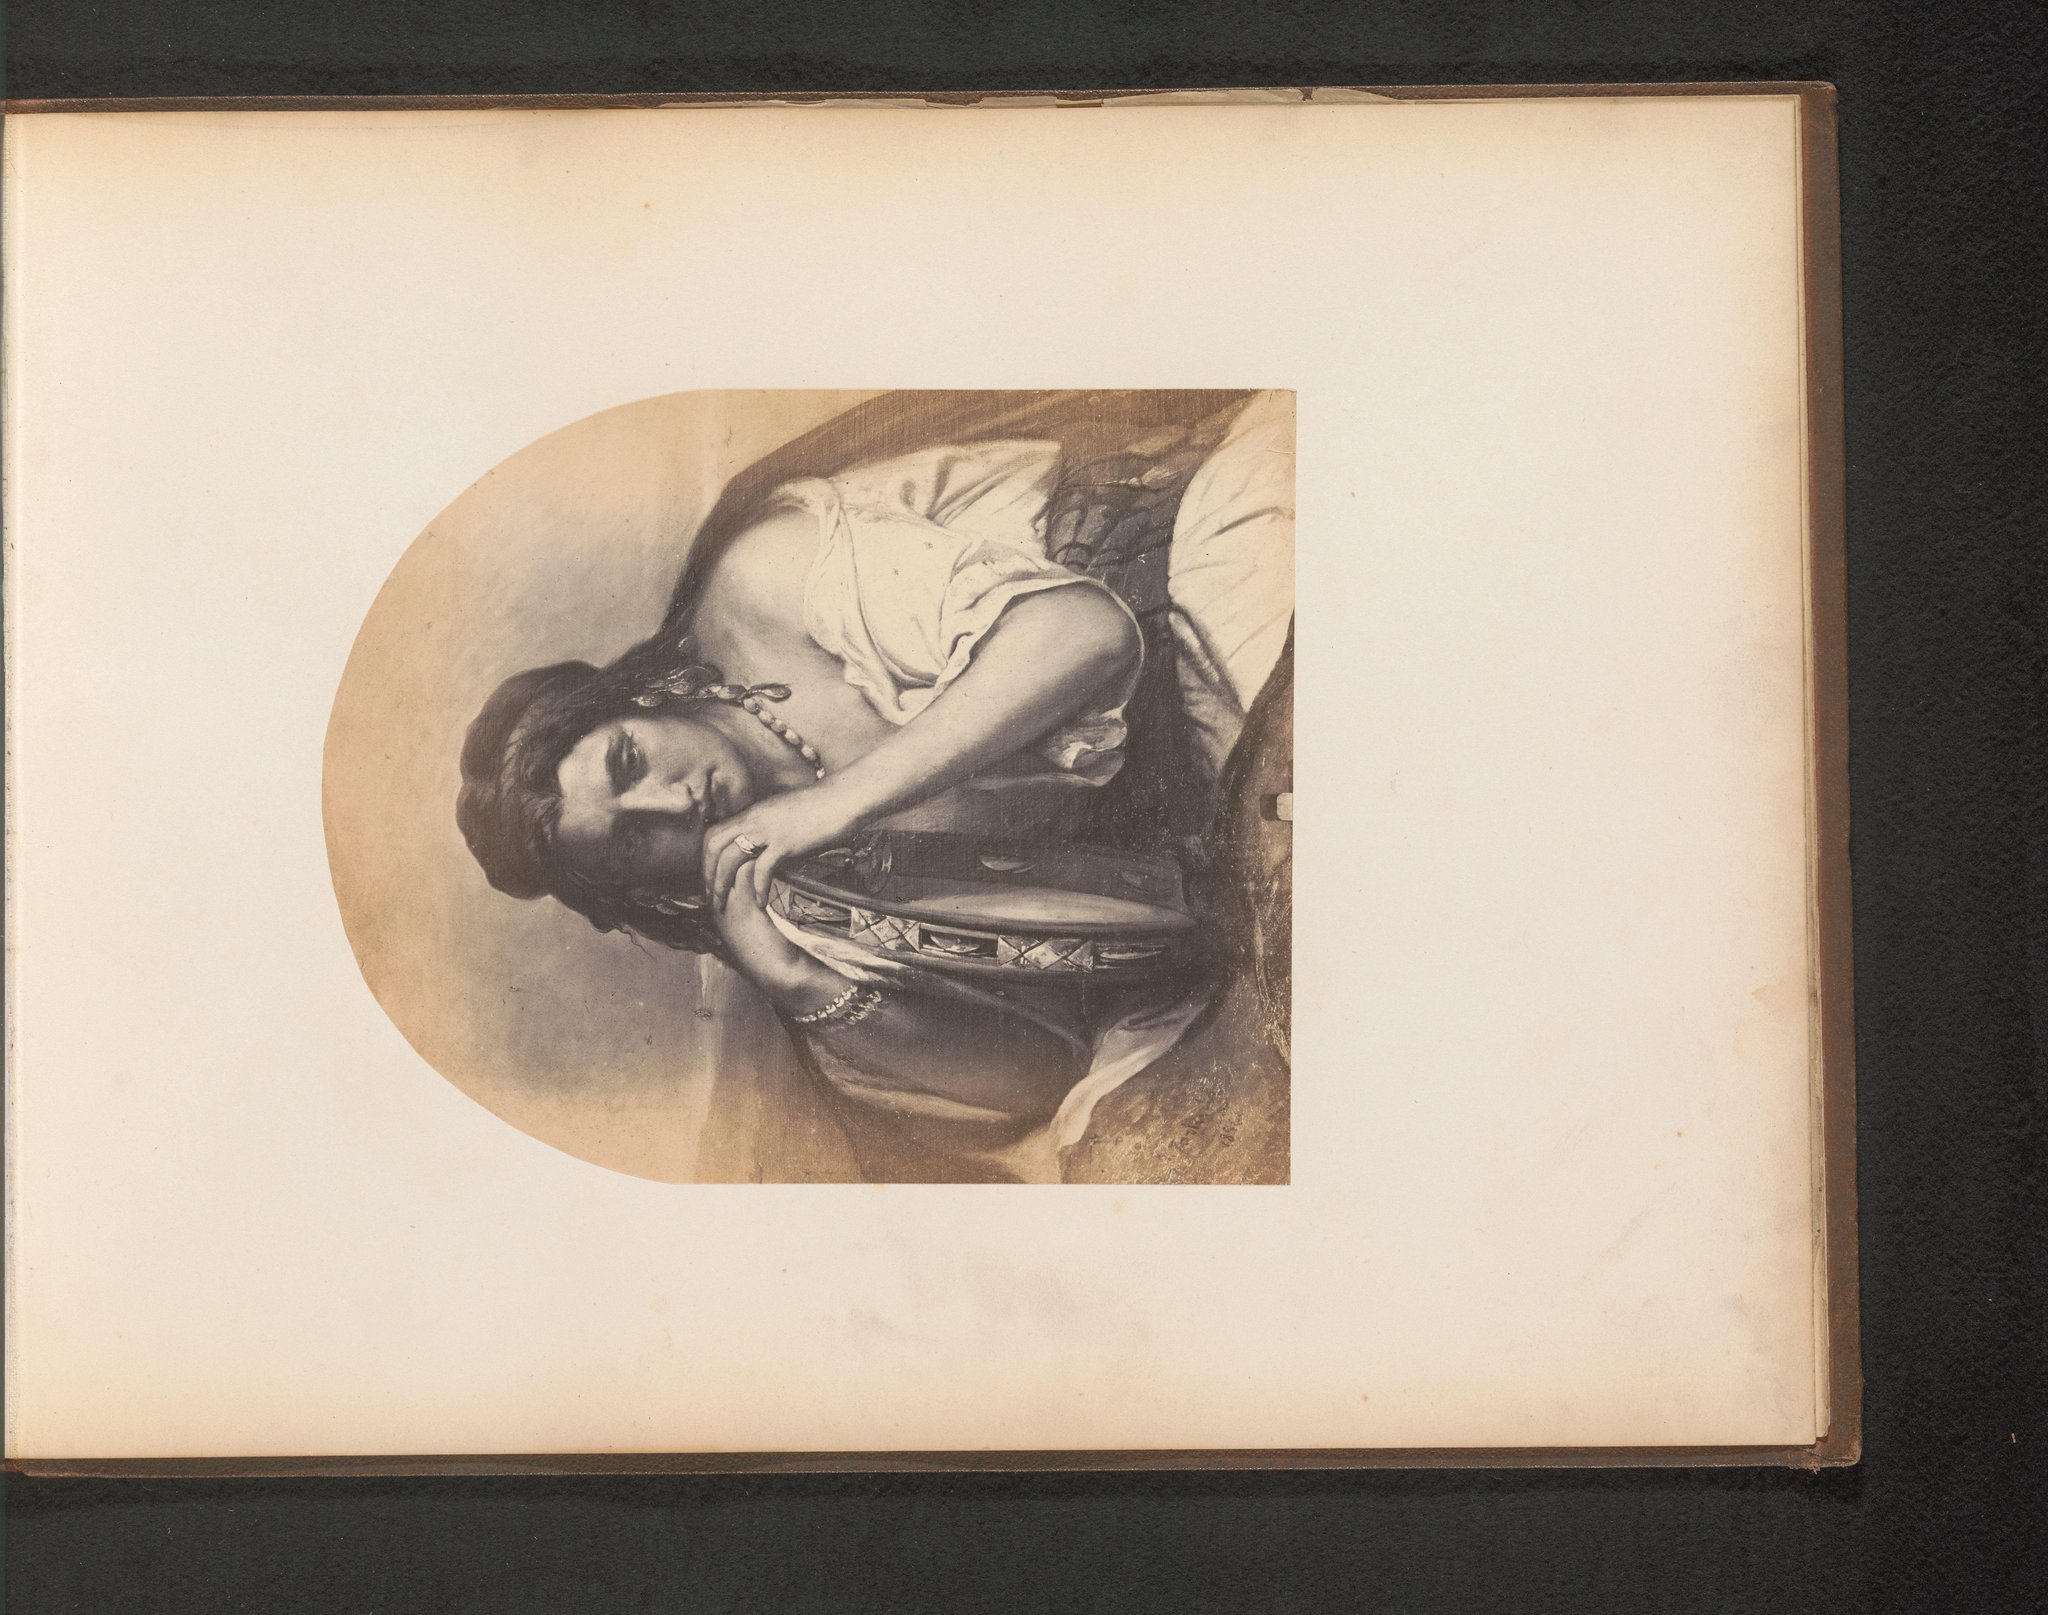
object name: reproduction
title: Fotoreproductie van Bohémienne d'Asie van Jan Frans Portaels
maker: Anonymous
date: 1858-1863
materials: photographic support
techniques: albumen print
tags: adult woman, tambourine, picture, painting